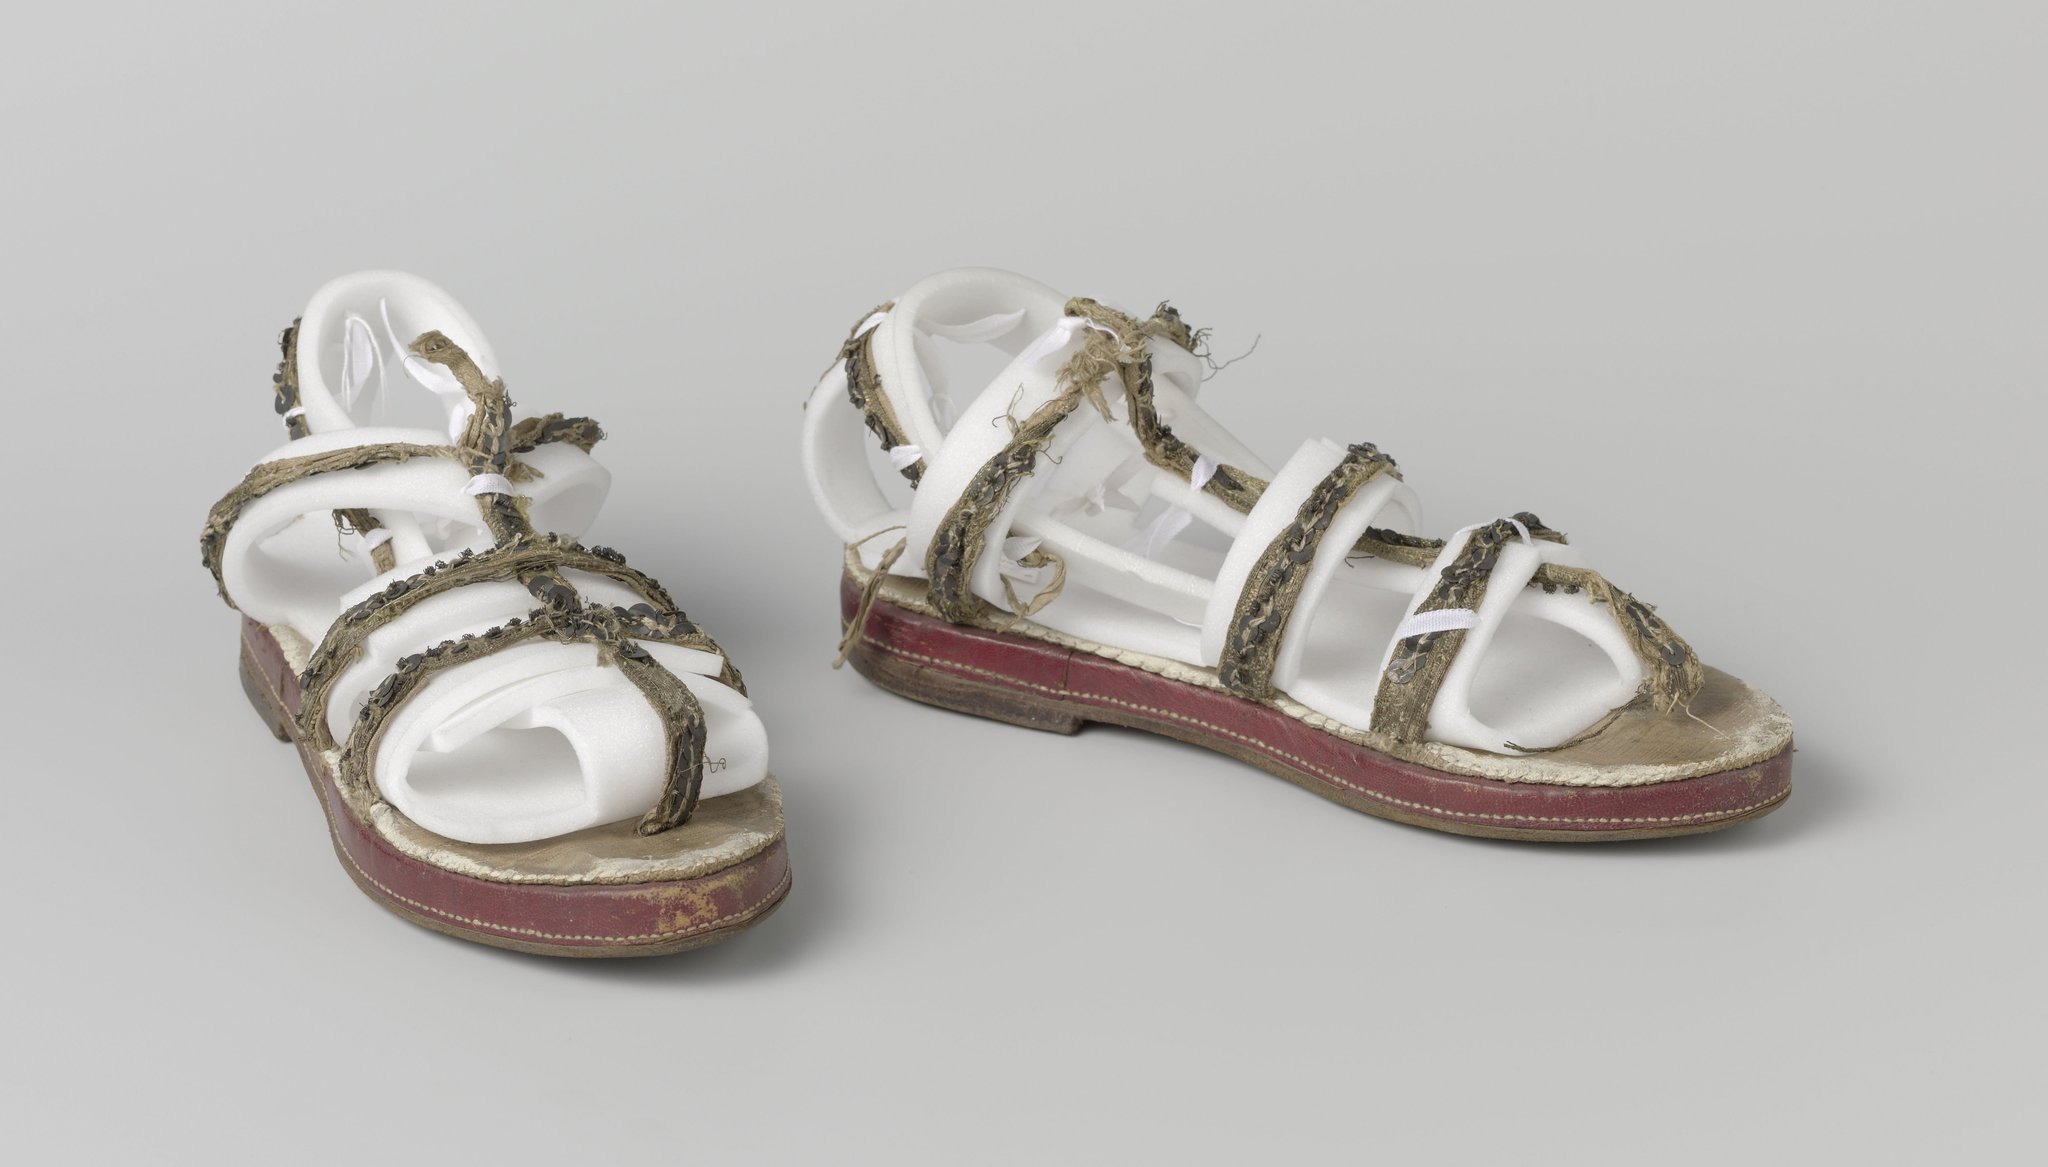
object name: clothing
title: Sandaal met dikke zolen bekleed met rood leer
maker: Anonymous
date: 1700-1800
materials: leather, linen, metal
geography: taiwan strait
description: Een paar sandalen, waarschijnlijk voor heren. Dikke, met rood leer overtrokken zolen, die linkse en rechtse vormen vertonen. Banden, ook naast de grote teen, van linnen met gouddraad en lovertjes. Versleten en vuil.